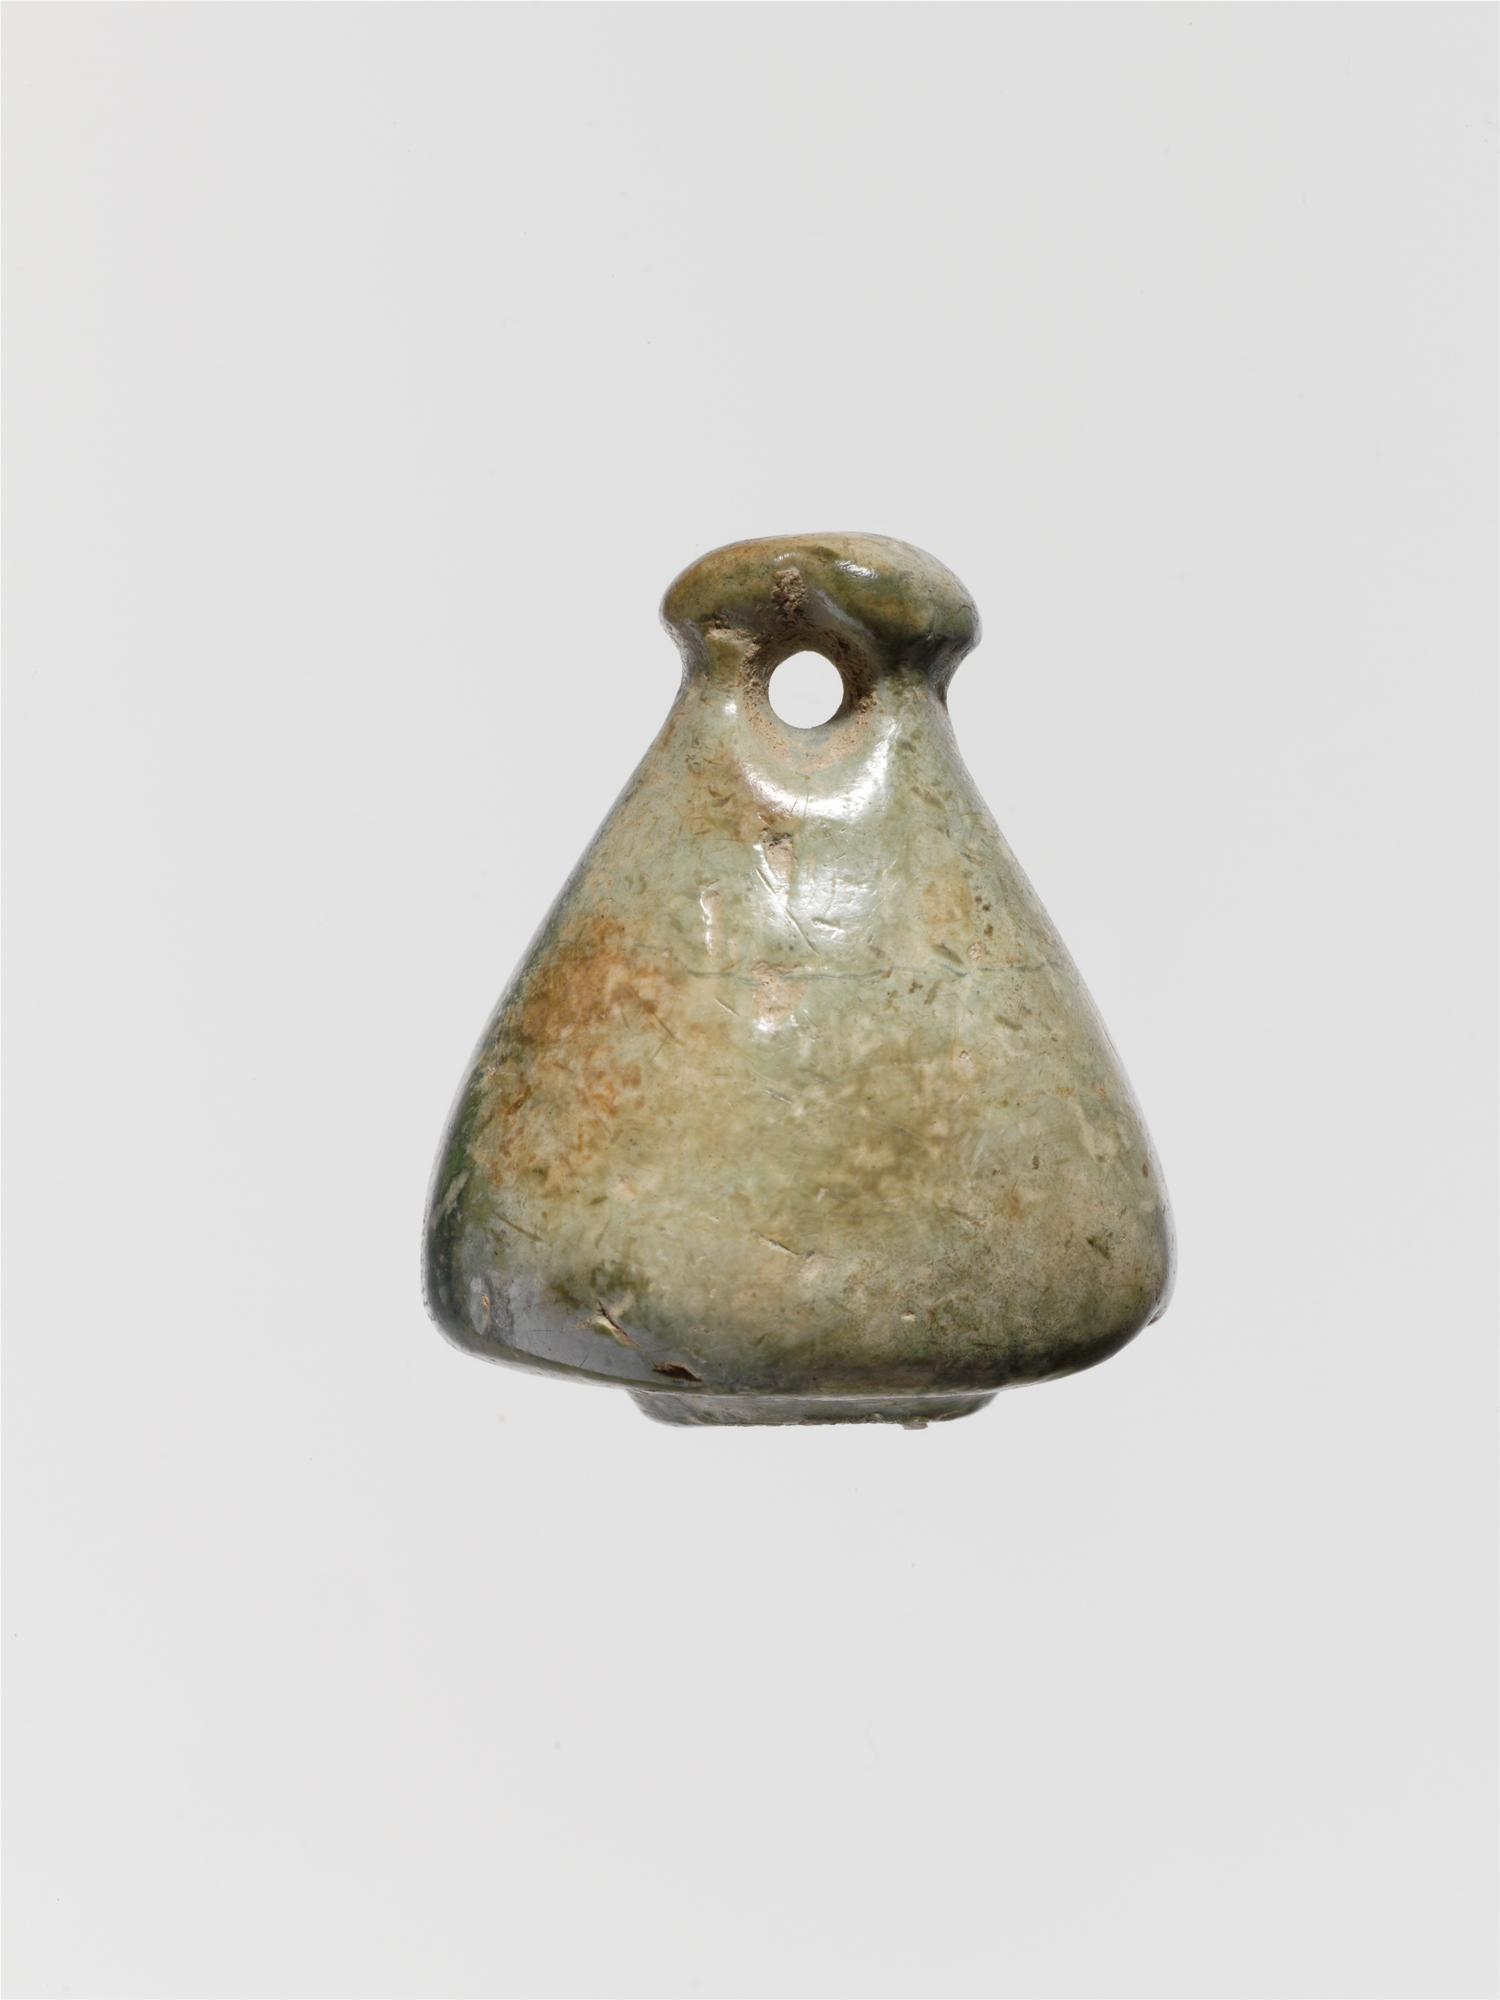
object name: pendant or weight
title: Serpentinite pendant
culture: cypriot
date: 3900-2500 BCE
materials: stone